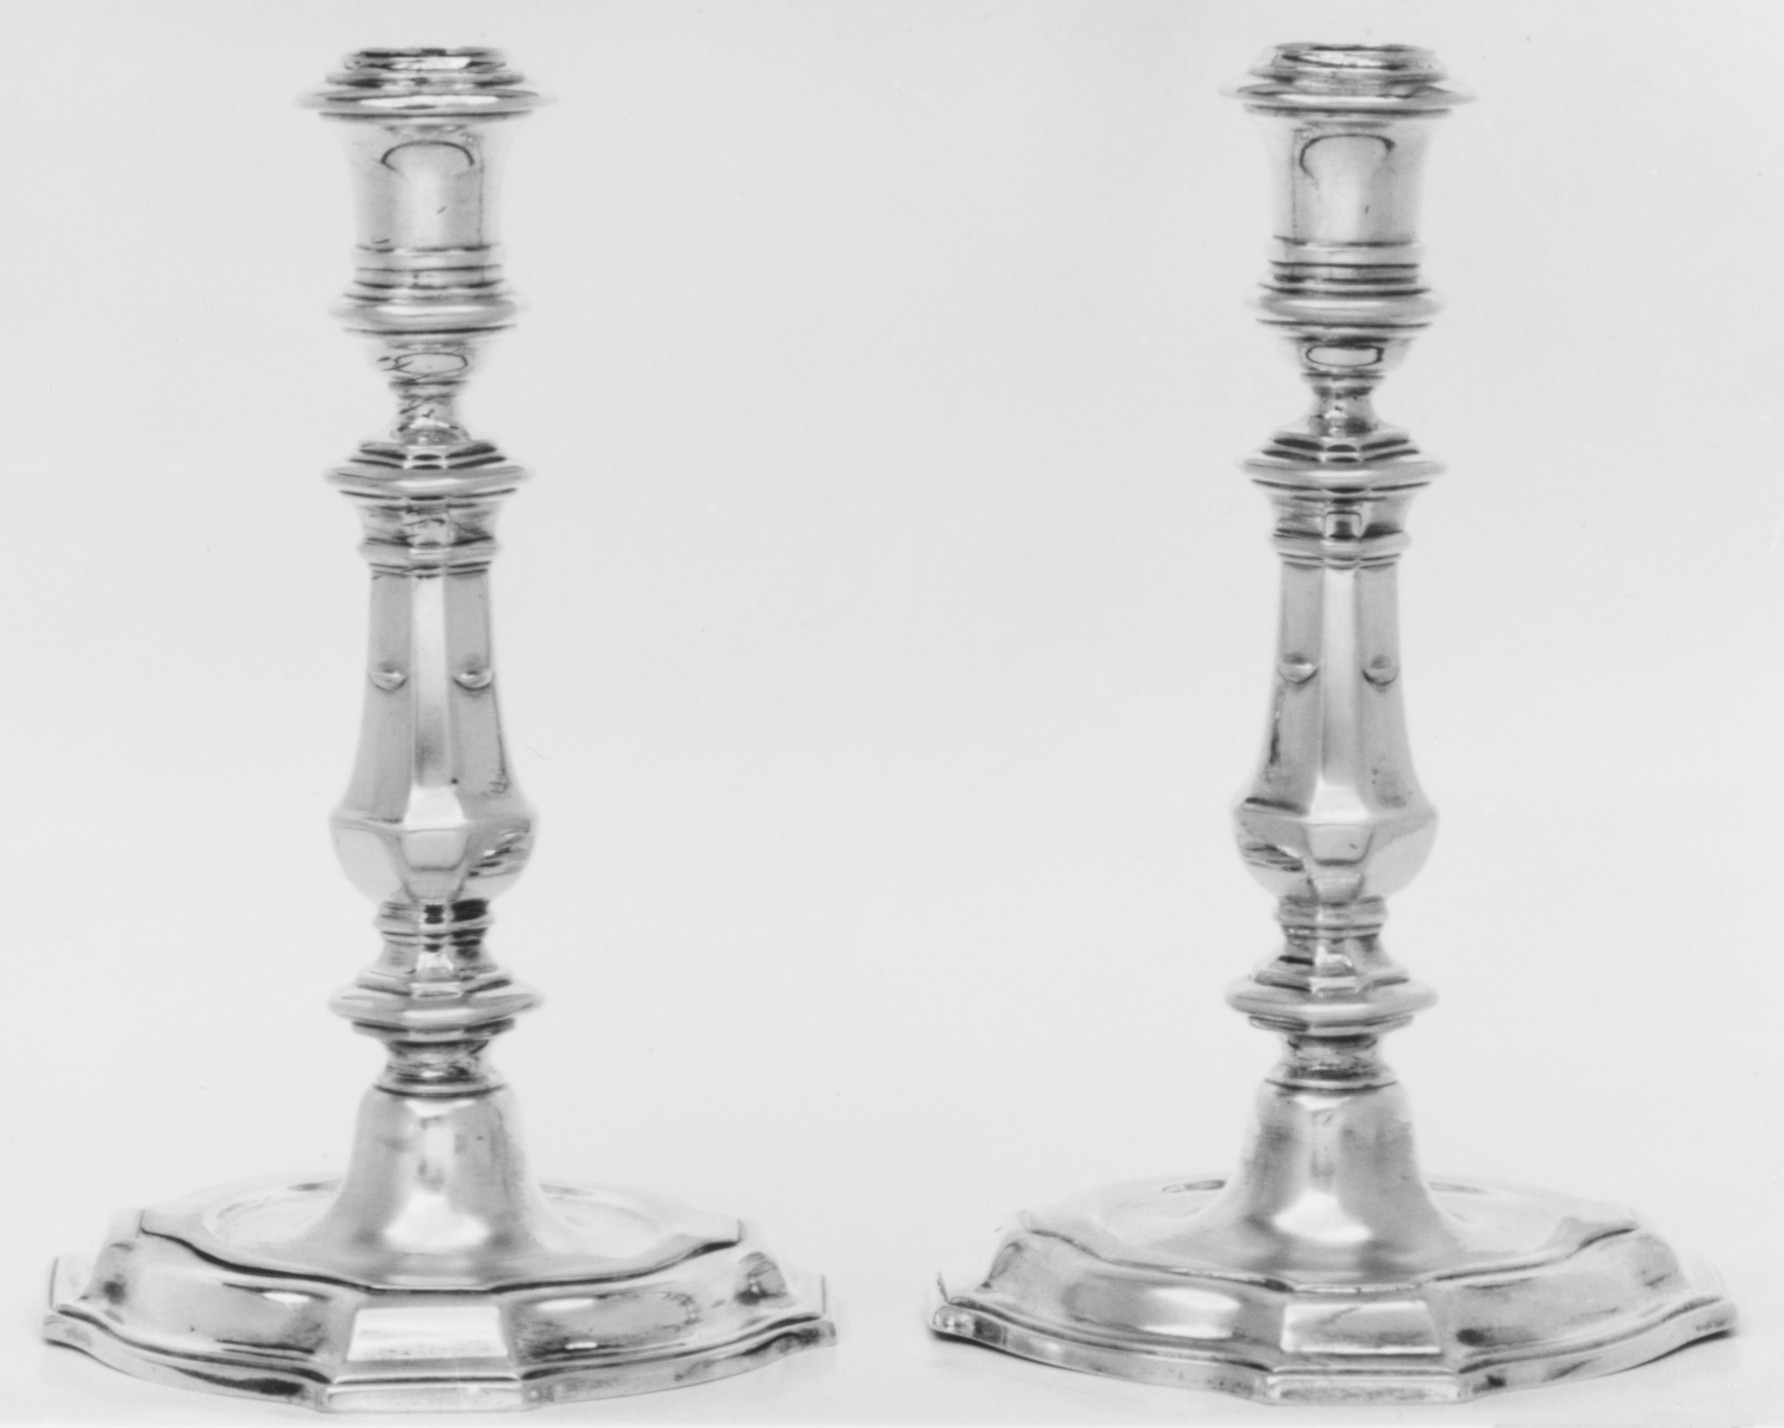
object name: candlestick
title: Candlestick (one of a pair)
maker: anthony de rooy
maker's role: maker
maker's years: 1731-1754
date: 1732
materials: silver